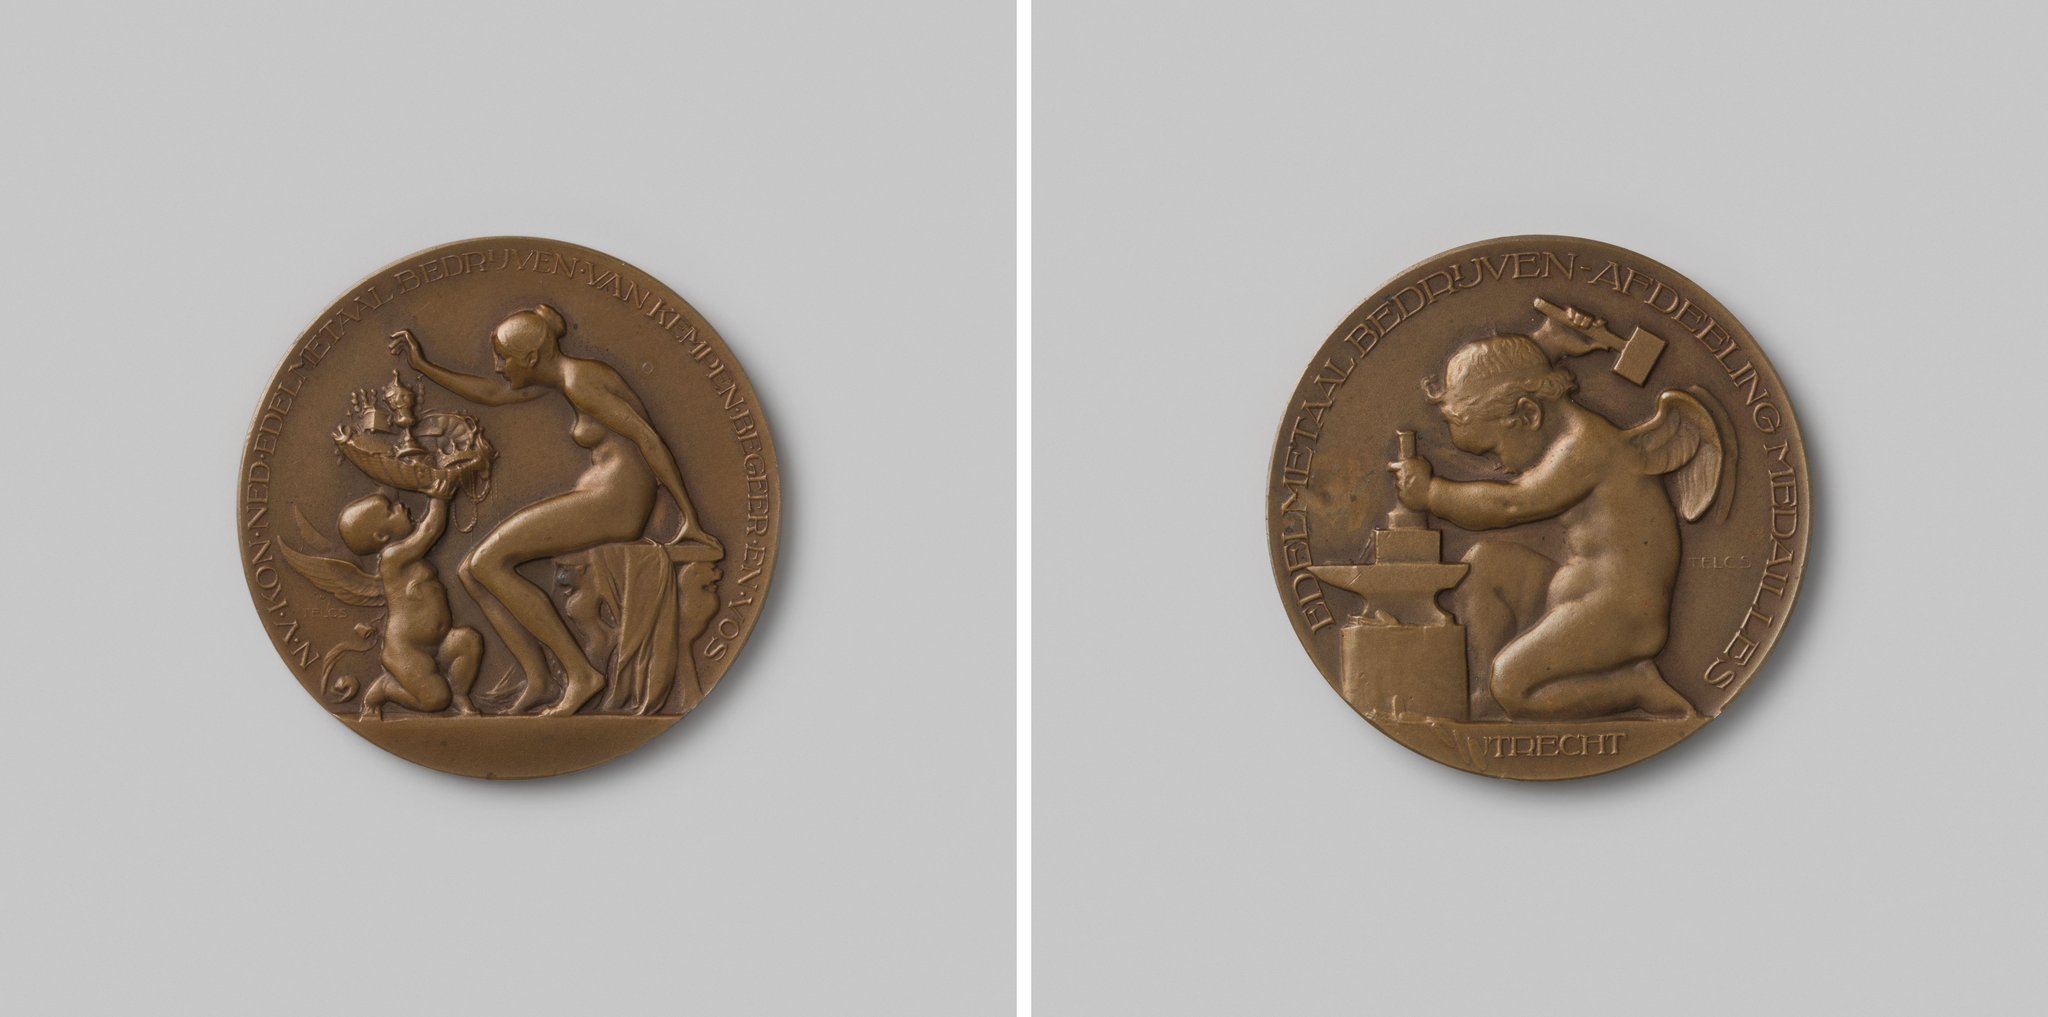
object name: adrespenning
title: N.V. Koninklijke Nederlandsche Edelmetaalbedrijven van Kempen, Begeer en Vos, Afdeeling Medailles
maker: eduard telcs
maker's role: medailleur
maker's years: 1872-1928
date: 1921-1922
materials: bronze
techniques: striking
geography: utrecht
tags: utrecht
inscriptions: inscription: ‘UTRECHT’, circumscription: ‘N.V. KON. NED. EDELMETAAL BEDRIJVEN VAN KEMPEN BEGEER EN VOS’, mark: ‘TELCS’, circumscription: ‘EDELMETAAL BEDRIJVEN-AFDEELING MEDAILLES’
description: Bronzen penning. Voorzijde: knielende genius houdt mand met goud- en zilverwerk, die hij boven zijn hoofd torst, voor aan zittende naakte vrouw, die met haar uitgestrekte rechterhand een van voorwerpen uit mand wil pakken binnen omschrift. Keerzijde: knielende genius met hamer in boven zijn hoofd geheven rechterhand en slagpons in linkerhand, is bezig om op aanbeeld munten te slaan binnen omschrift; afsnede: opschrift.